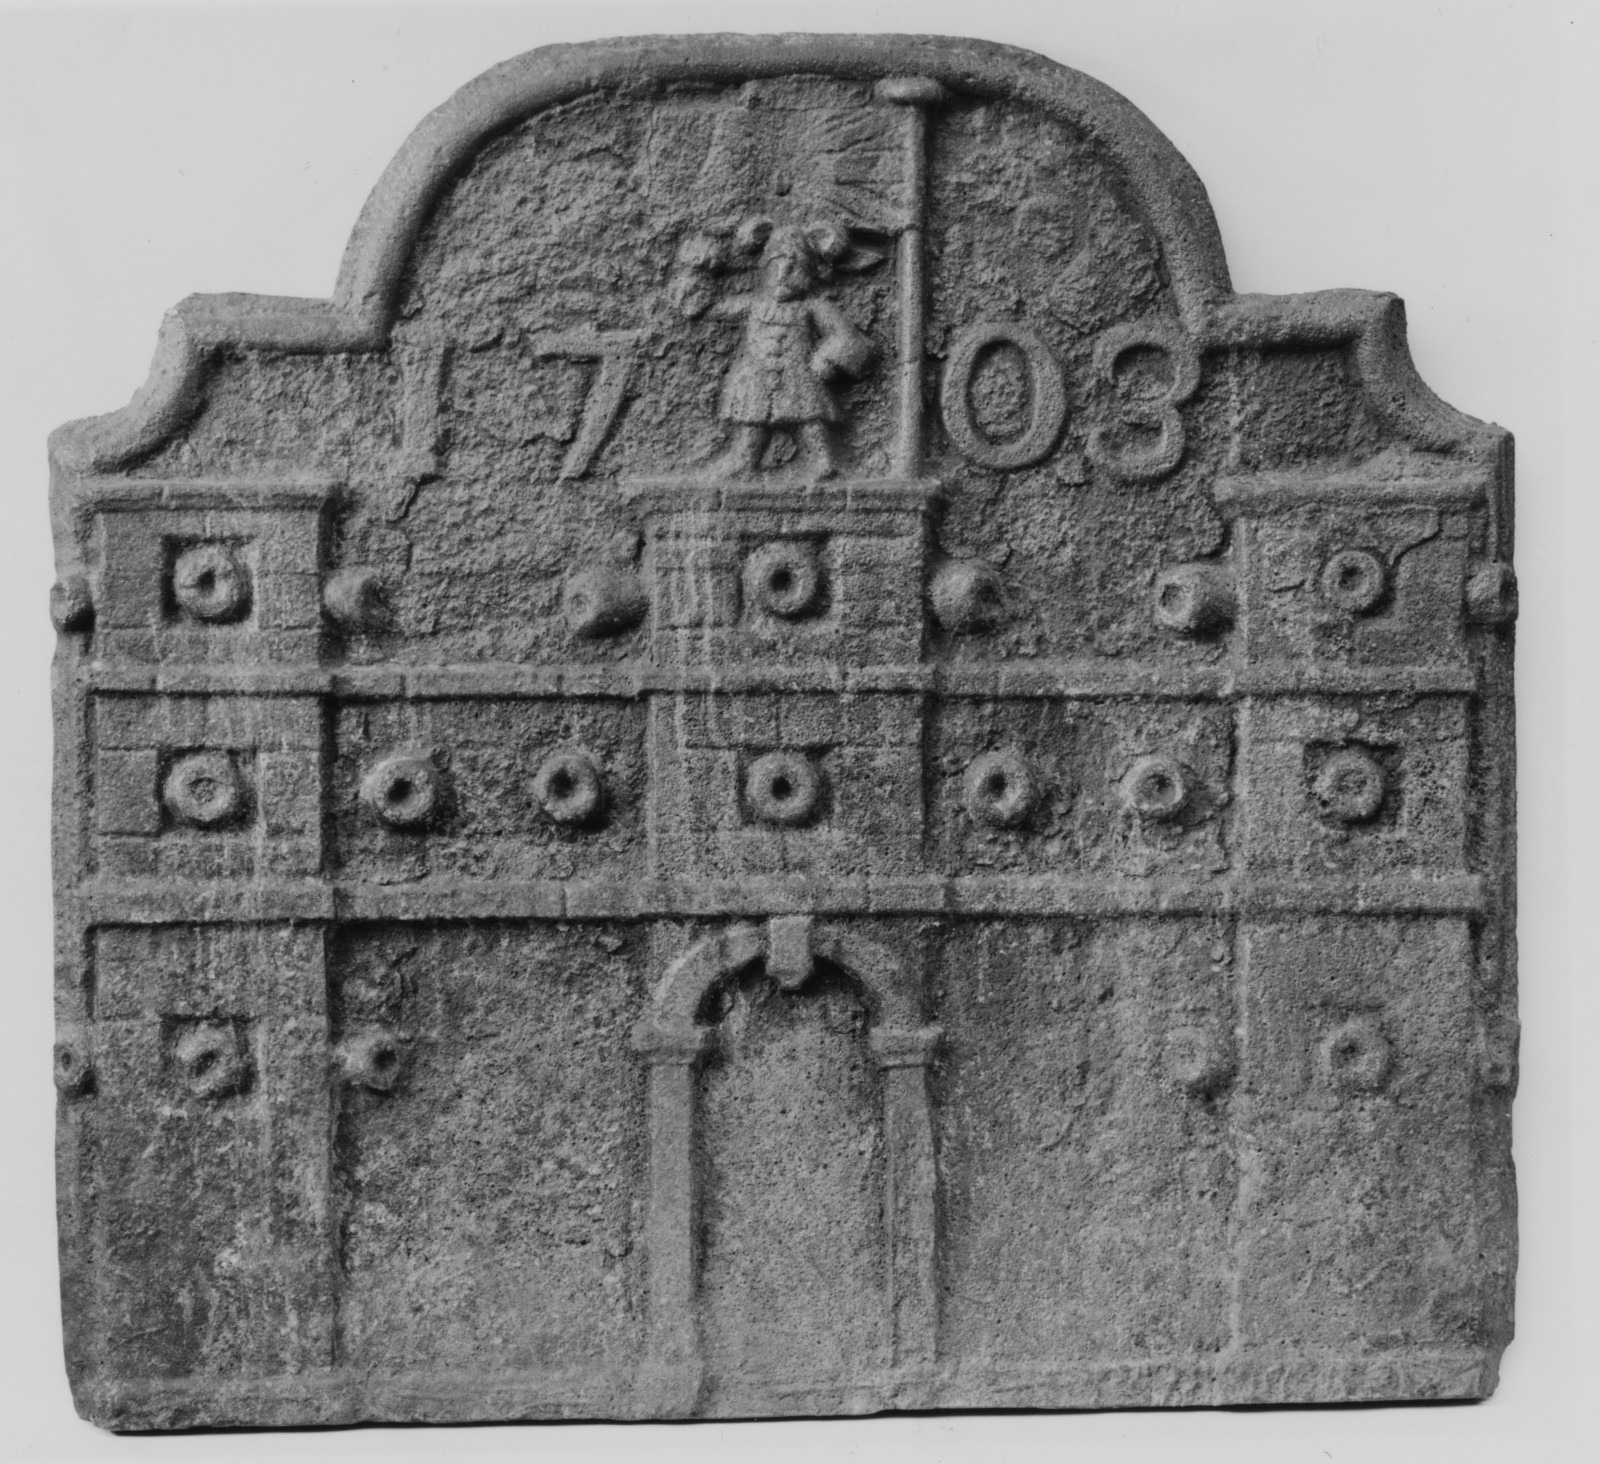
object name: fireback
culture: american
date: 1703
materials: iron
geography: united states